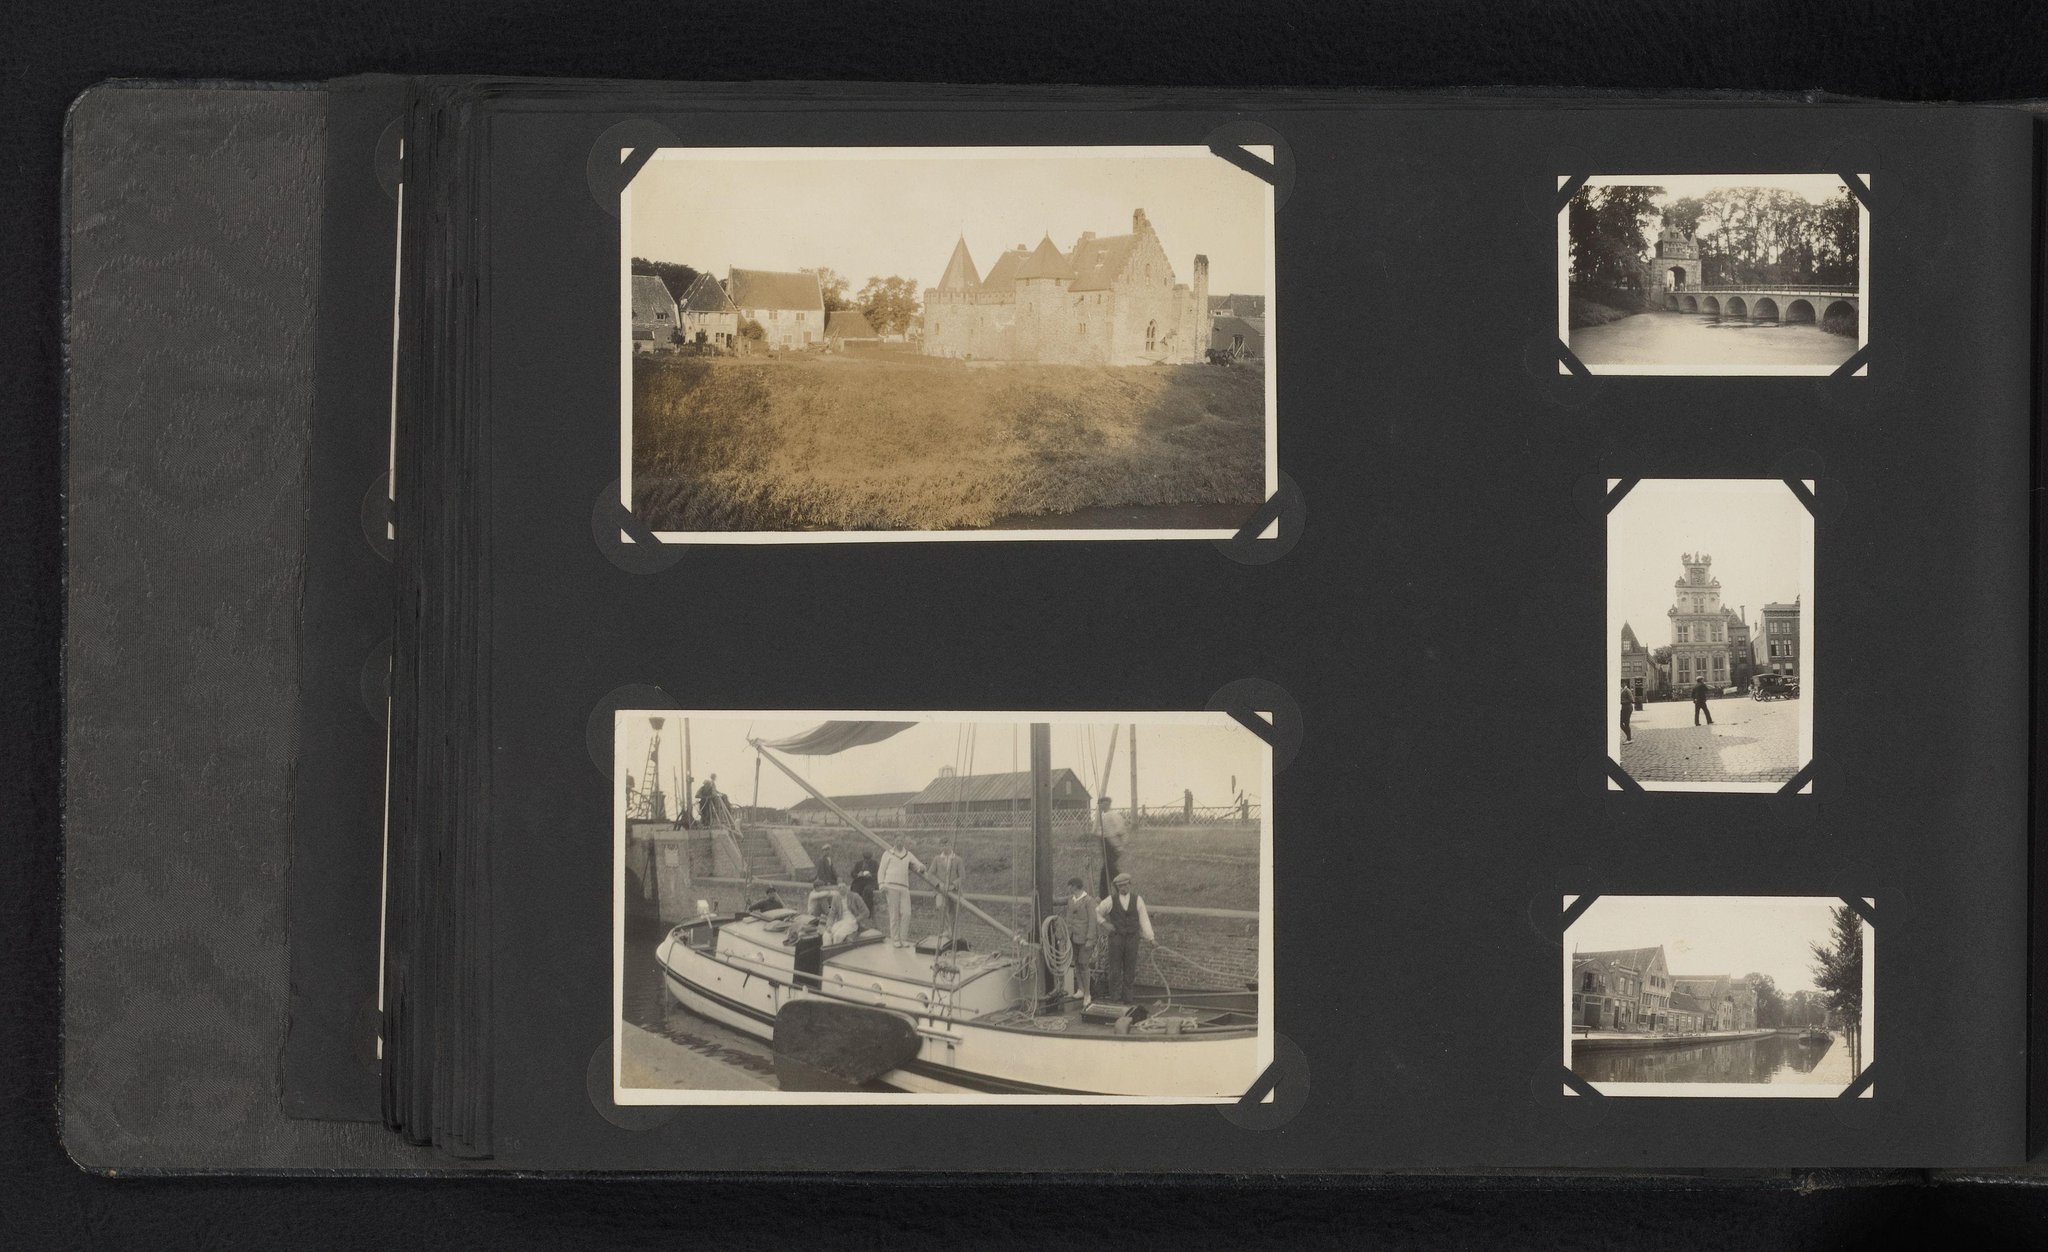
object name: photograph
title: Vijf foto's van een boottocht met zeilboot De Snits, onder andere in Stavoren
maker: hendrik herman van den berg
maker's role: amateurfotograaf, jurist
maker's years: 1875-1944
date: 1926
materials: paper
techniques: gelatin silver print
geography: netherlands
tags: sailing-ship, sailing-boat, castle, netherlands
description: Deze foto's maken deel uit van een album.